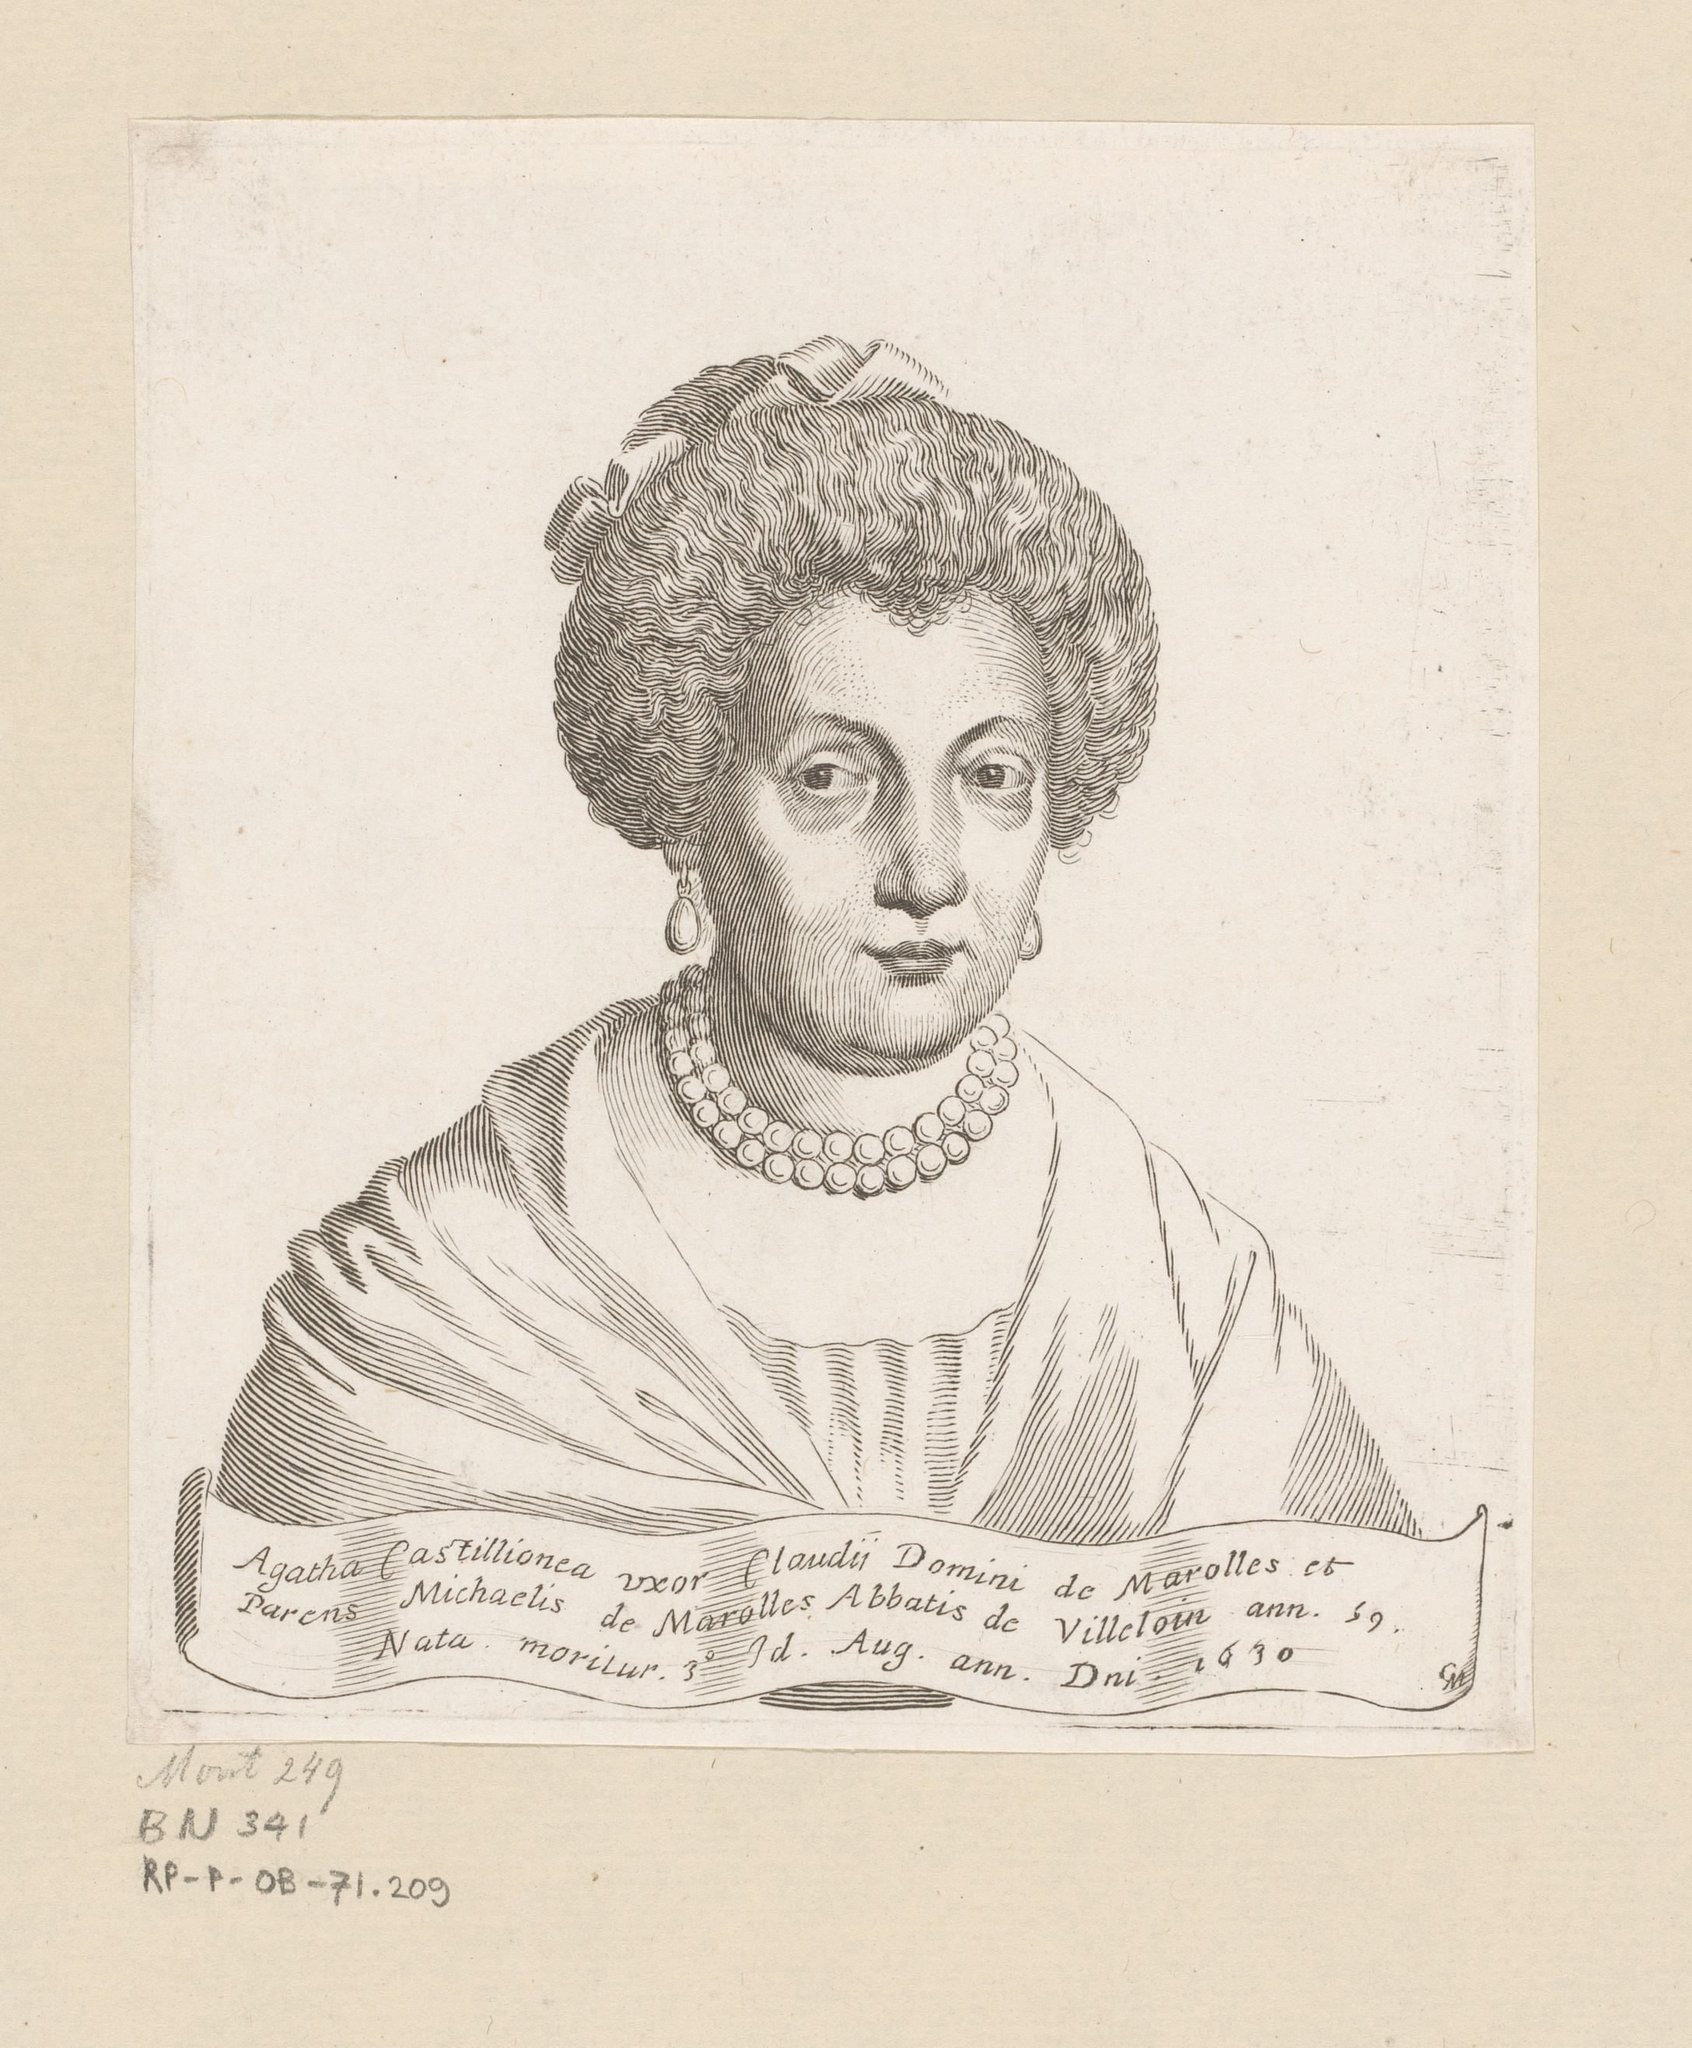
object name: print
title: Portret van Agathe de Châtillon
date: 1656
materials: paper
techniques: engraving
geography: france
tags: historical persons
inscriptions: collector's mark: Lugt 240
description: Prent gebruikt voor: Marolles, Michel de. Les Mémoires de Michel de Marolles, abbé de Villeloin. Parijs: Antoine de Sommaville, 1656.